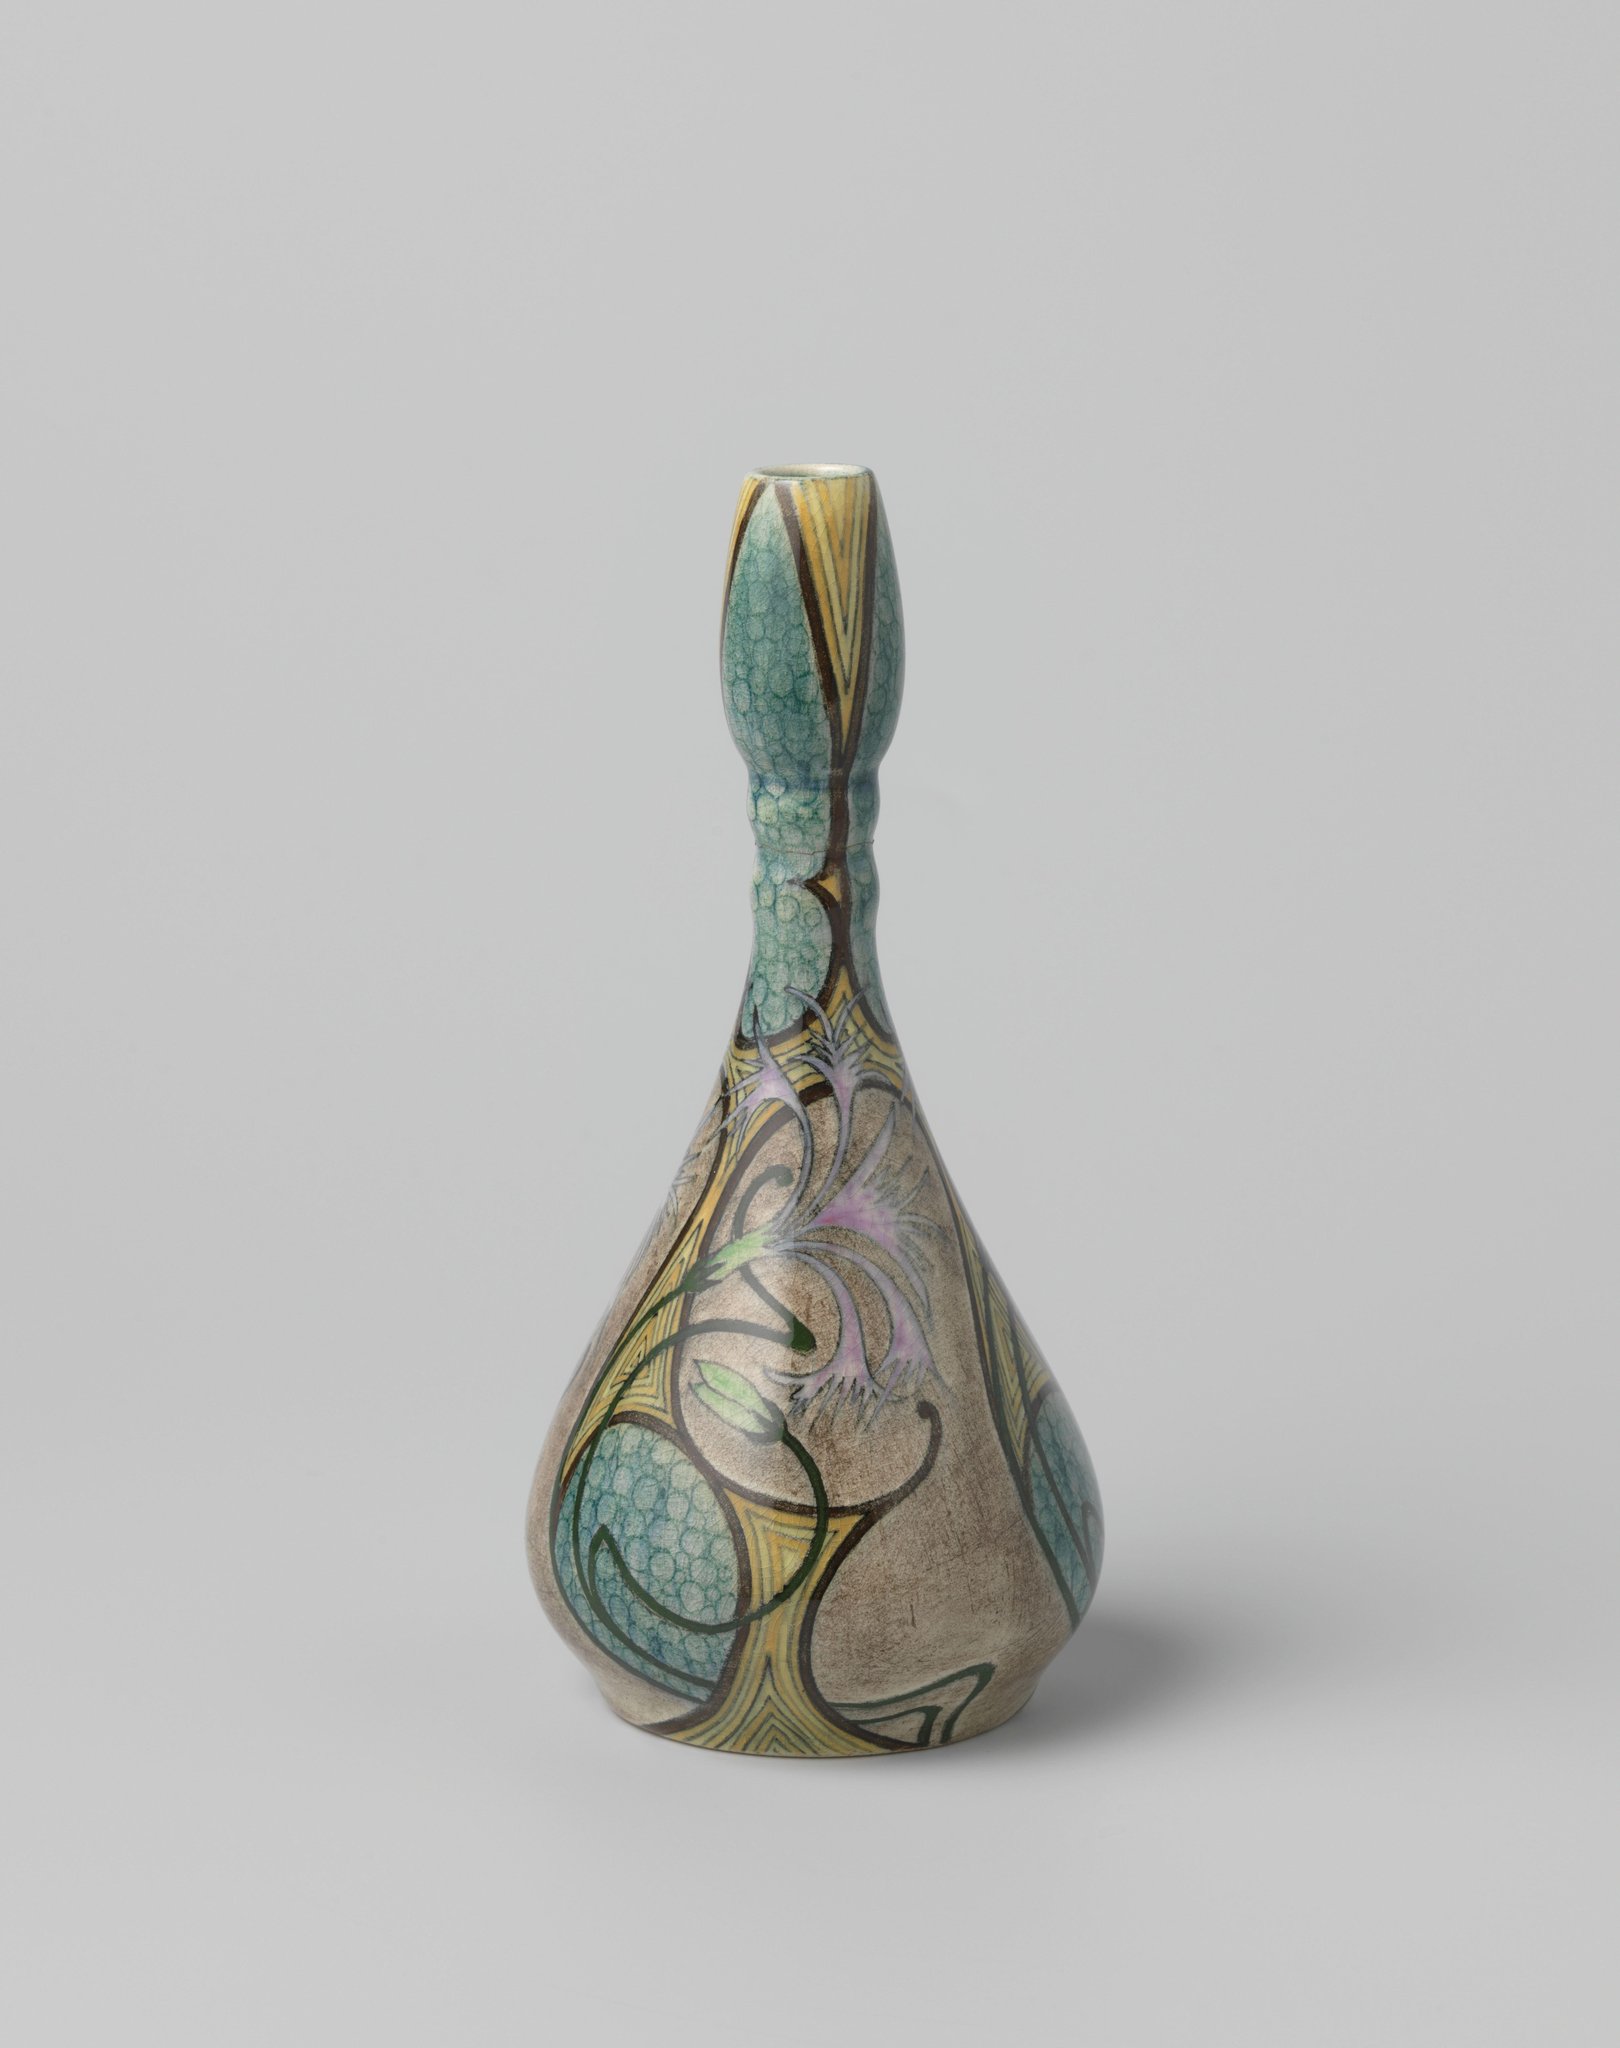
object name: vase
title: Vaas met bloemen en ornamentale lijnen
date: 1895-1904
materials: earthenware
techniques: painted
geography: purmerend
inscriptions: mark: ‘klomp/NB/Faience/de/Purmerende/Hollande, 1133 Dec: A,AS.F.’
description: Two vases. Earthenware. Purmerend, 1901, made by Firma Wed. N.S.A. Brantjes, decorated by Hendrikus W. Dekkers and Albert Seinstra, factory under the direction of the widow of N.S.A. Brantjes.